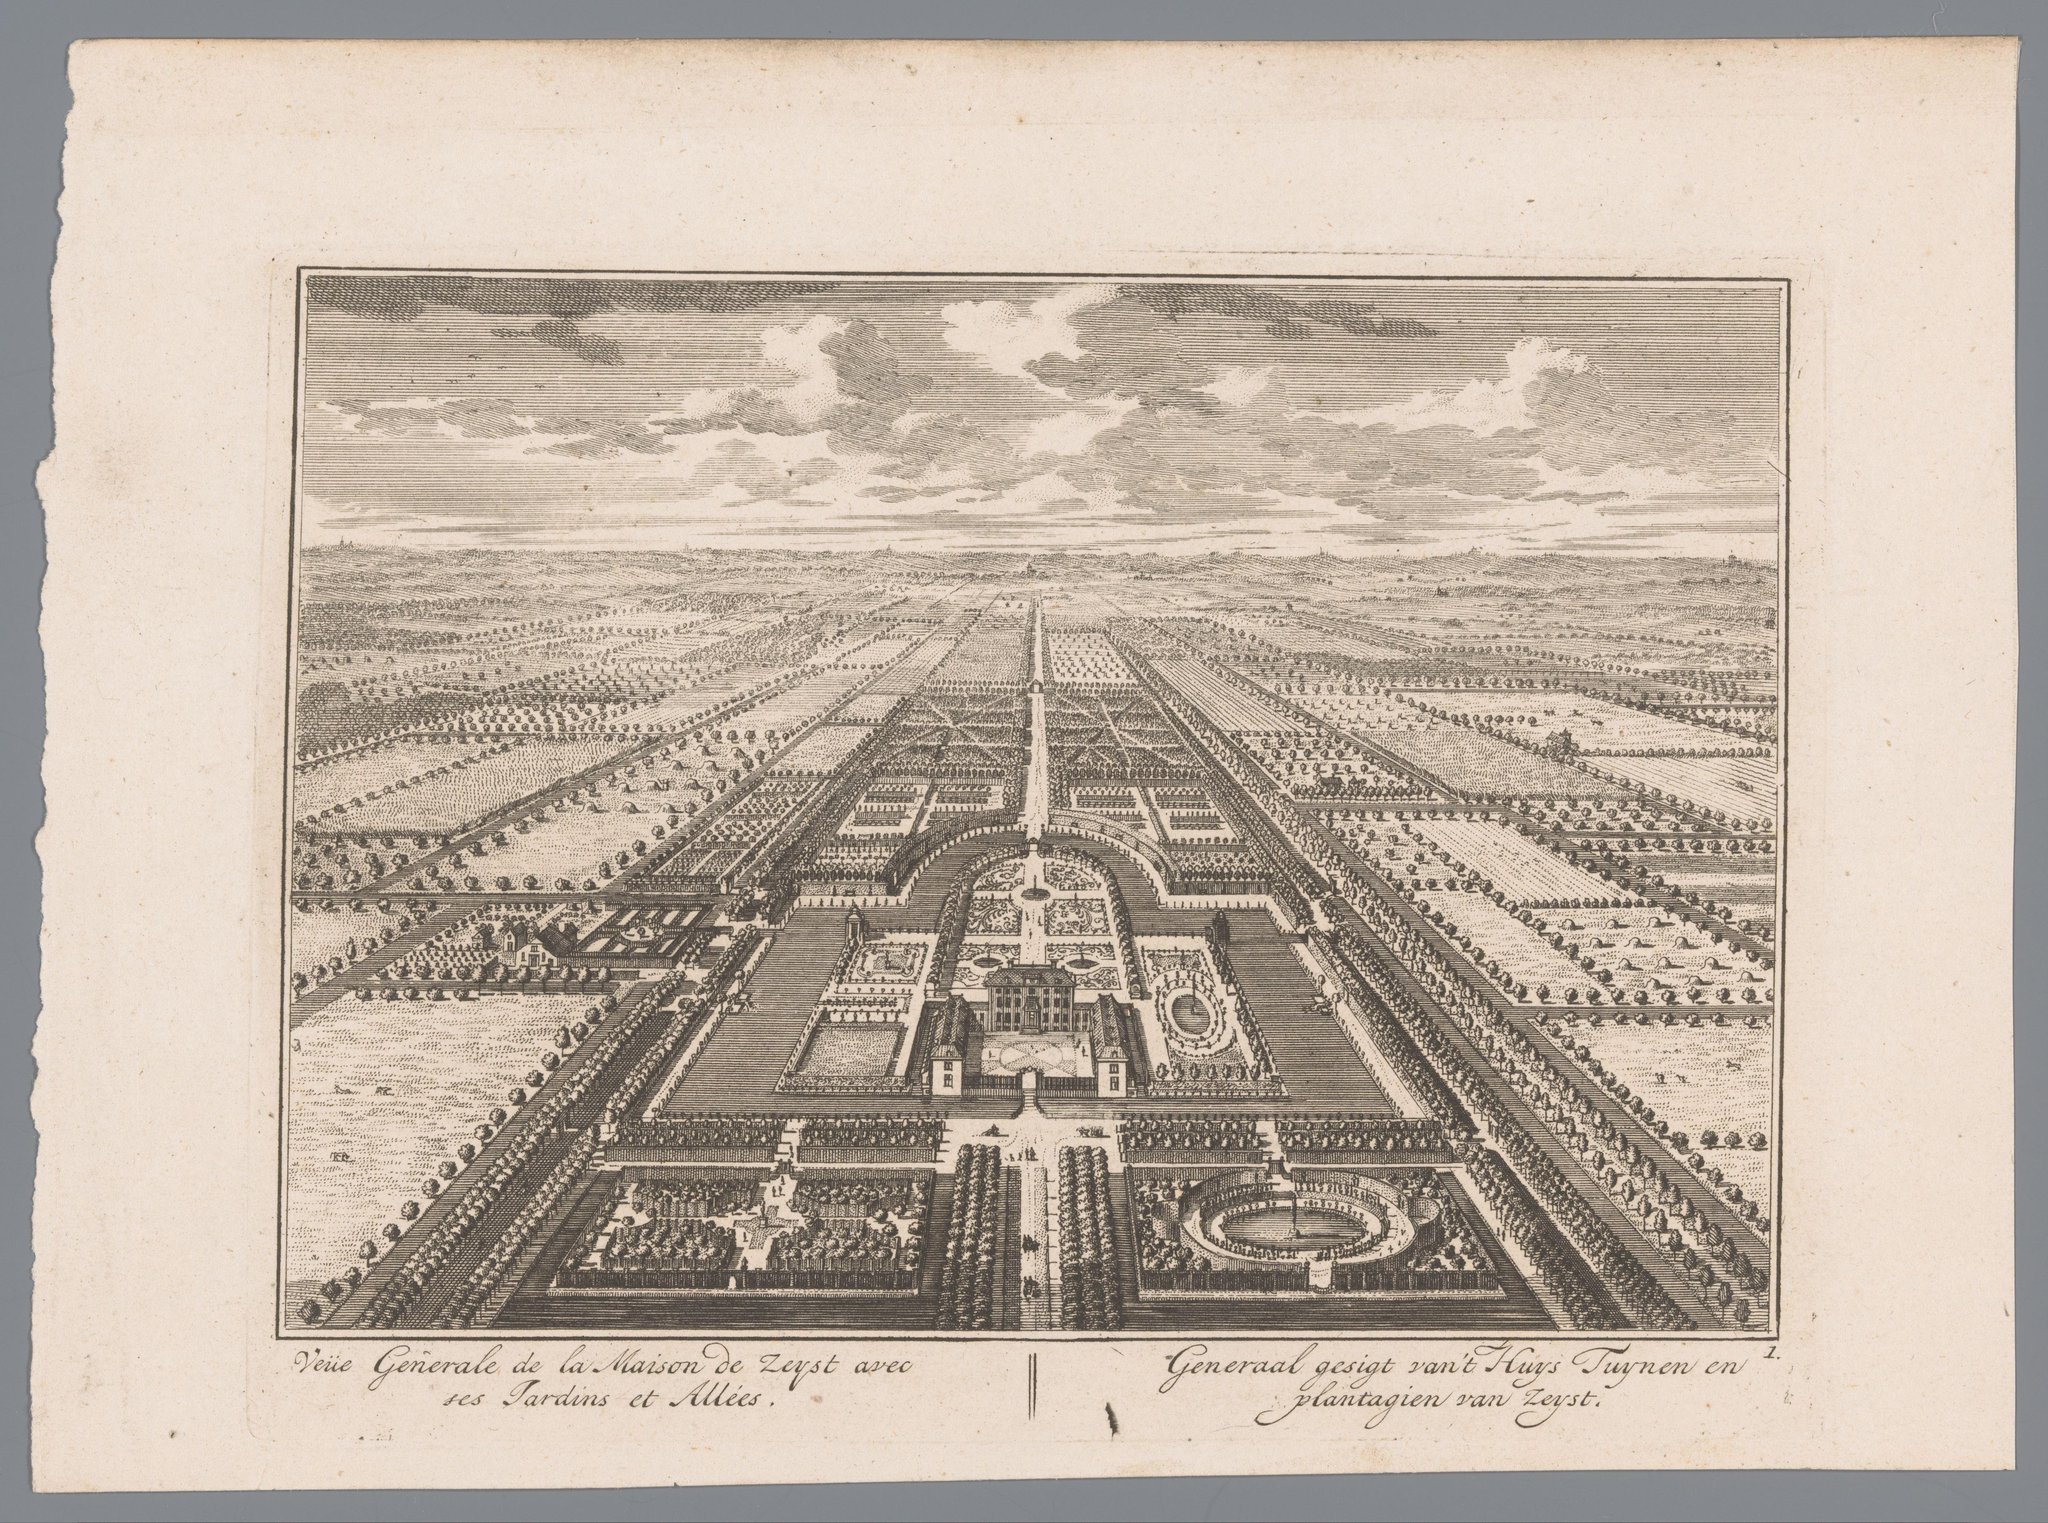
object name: print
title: Veüe generale de la maison de Zeyst avec ses jardins et allées / Generaal gesigt van't huys tuynen en plantagien van Zeyst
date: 1682-1726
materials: paper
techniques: etching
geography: amsterdam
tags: castle, landscape with tower or castle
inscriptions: collector's mark: Lugt 2233